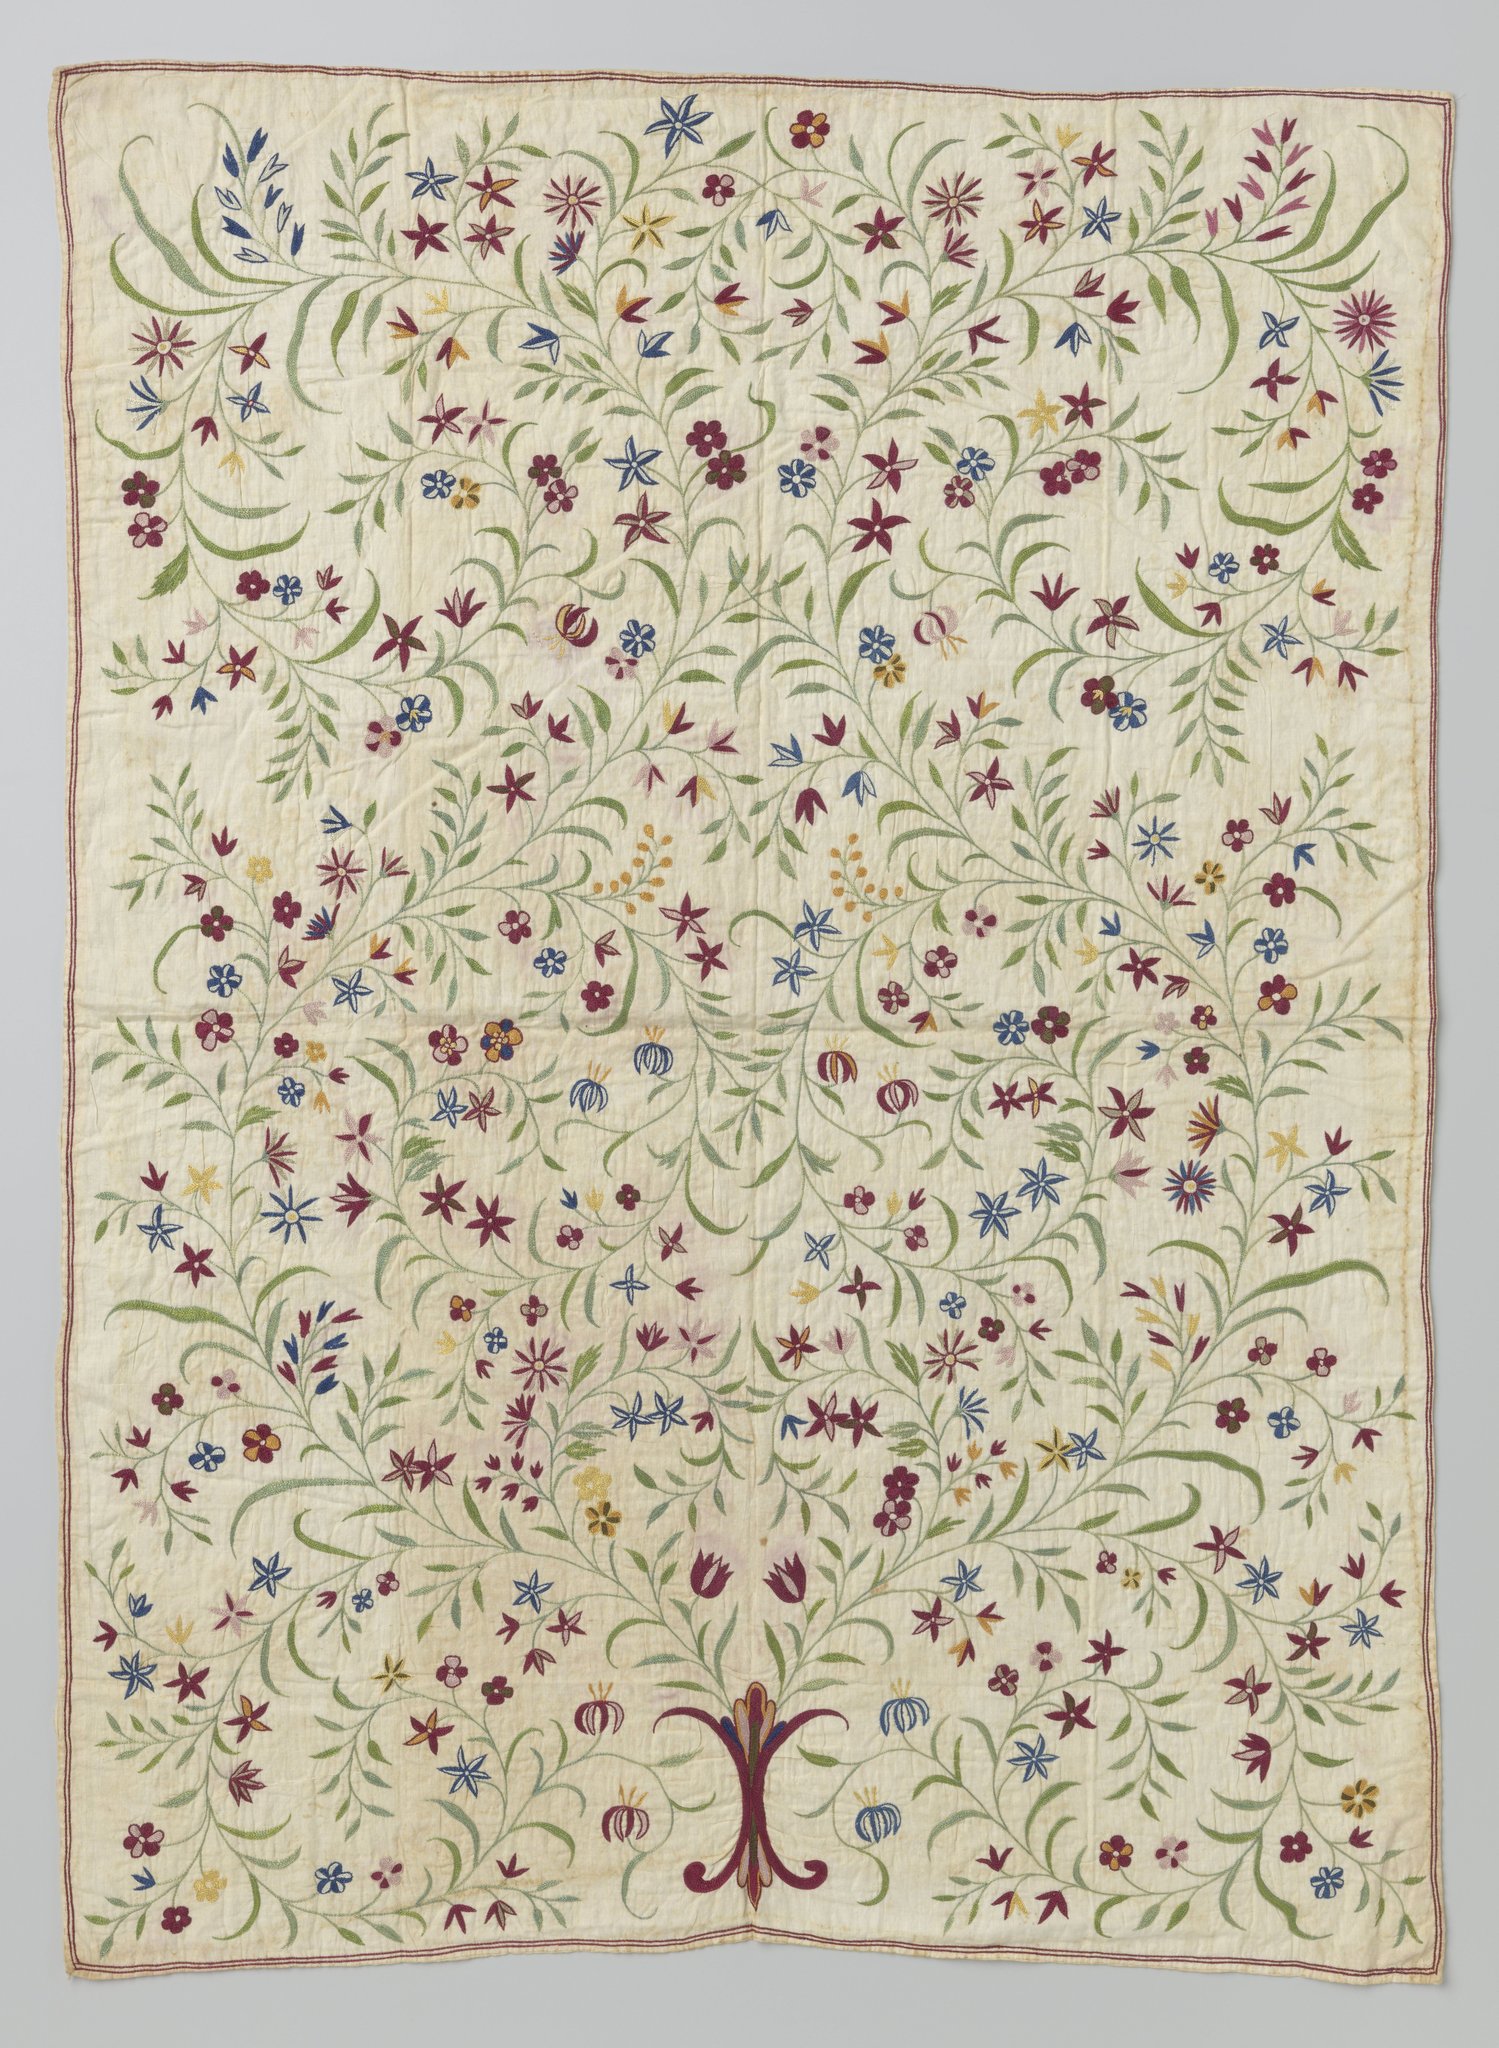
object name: textile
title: Kleed van oosterse textiel; met veelkleurig borduurwerk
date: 1800-1899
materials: cotton, silk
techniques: embroidered, weave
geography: east indies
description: Kleed van veelkleurig getamboereerde katoen, versierd met bloemranken en ornament, gevoerd met katoen.